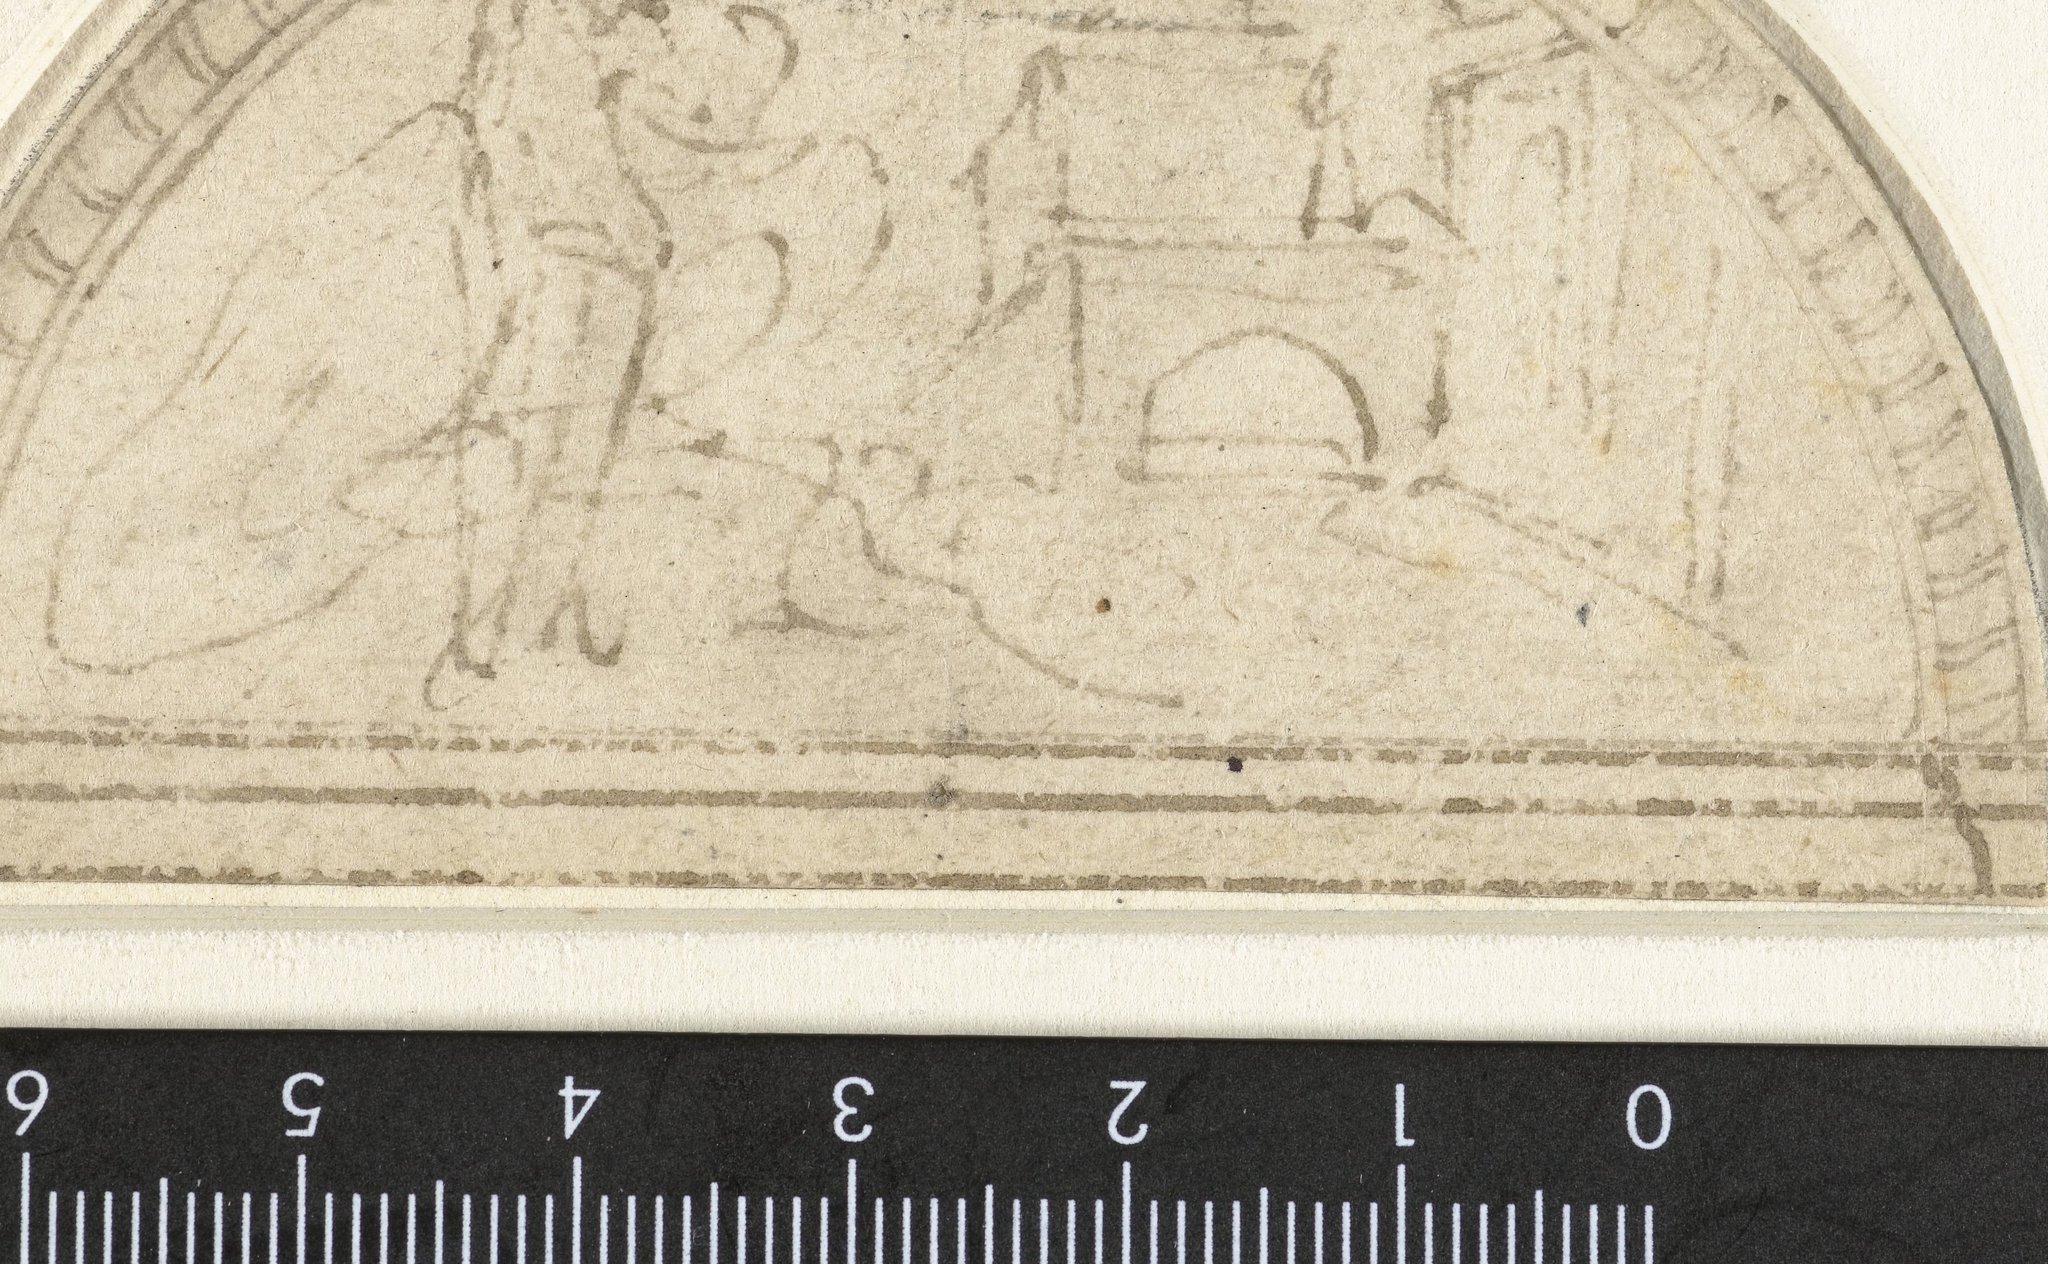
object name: drawing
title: Ornament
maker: perino del vaga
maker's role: draughtsman, painter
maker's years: 1501-1547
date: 1520-1547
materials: ink, paper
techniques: pen